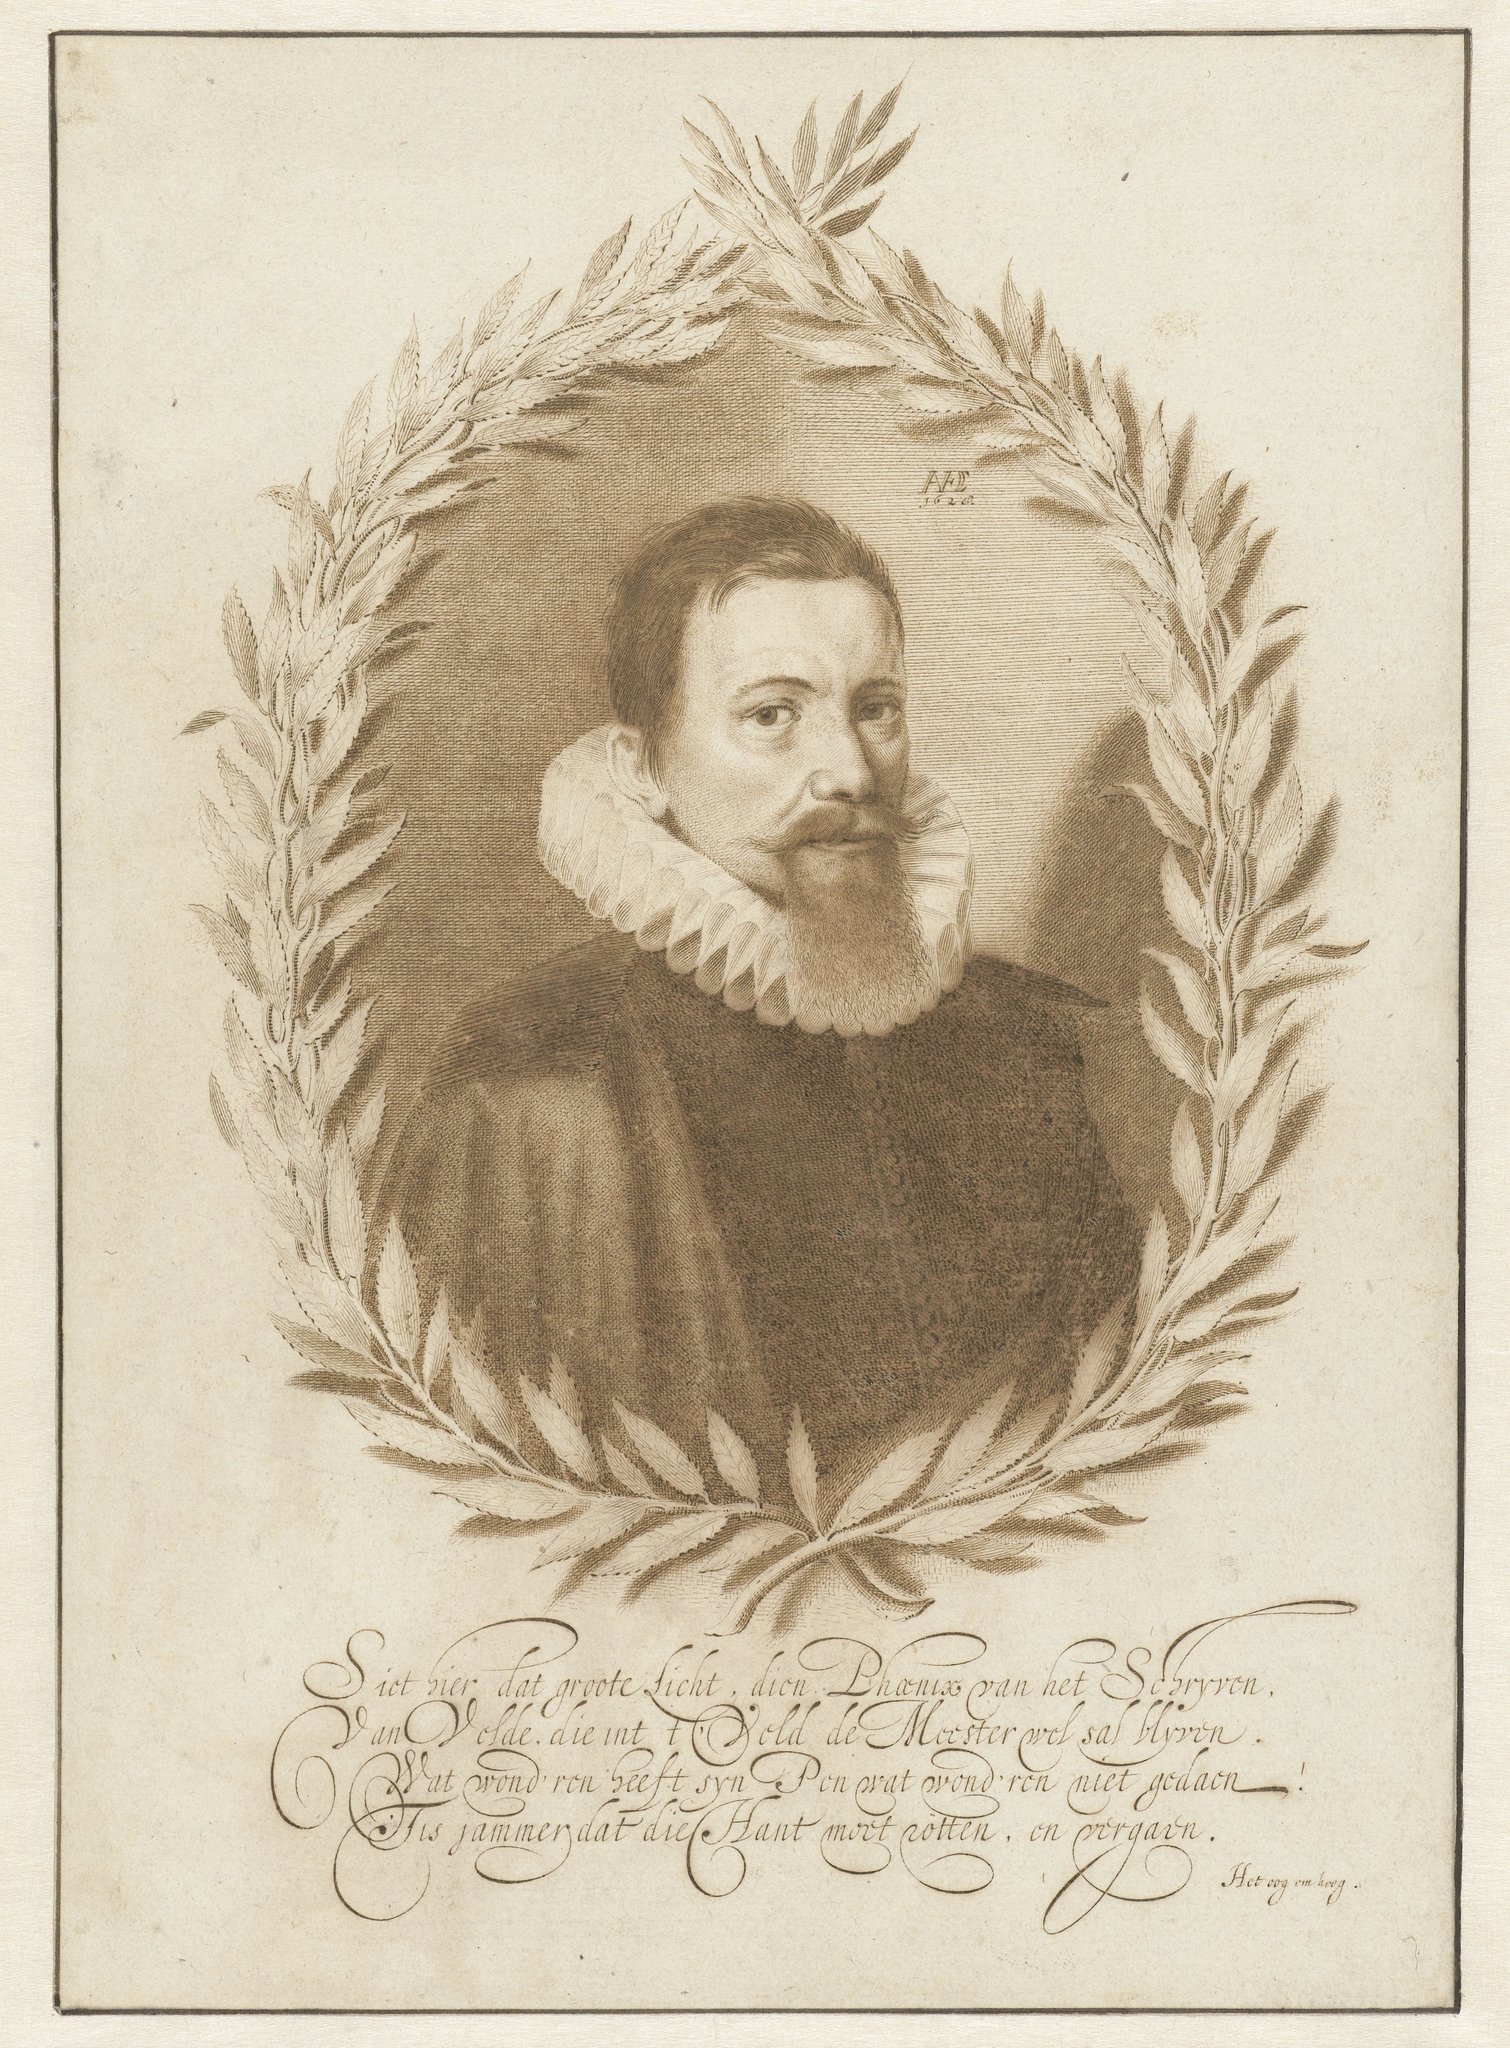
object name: drawing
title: Portret van Jan van de Velde (I)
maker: jan van de velde (ii)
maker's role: draughtsman, painter, print maker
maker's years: 1593-1641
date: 1628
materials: ink, paper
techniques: pen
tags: haarlem, jan van de velde (i), historical persons, calligraphy, portrait, self-portrait of draughtsman